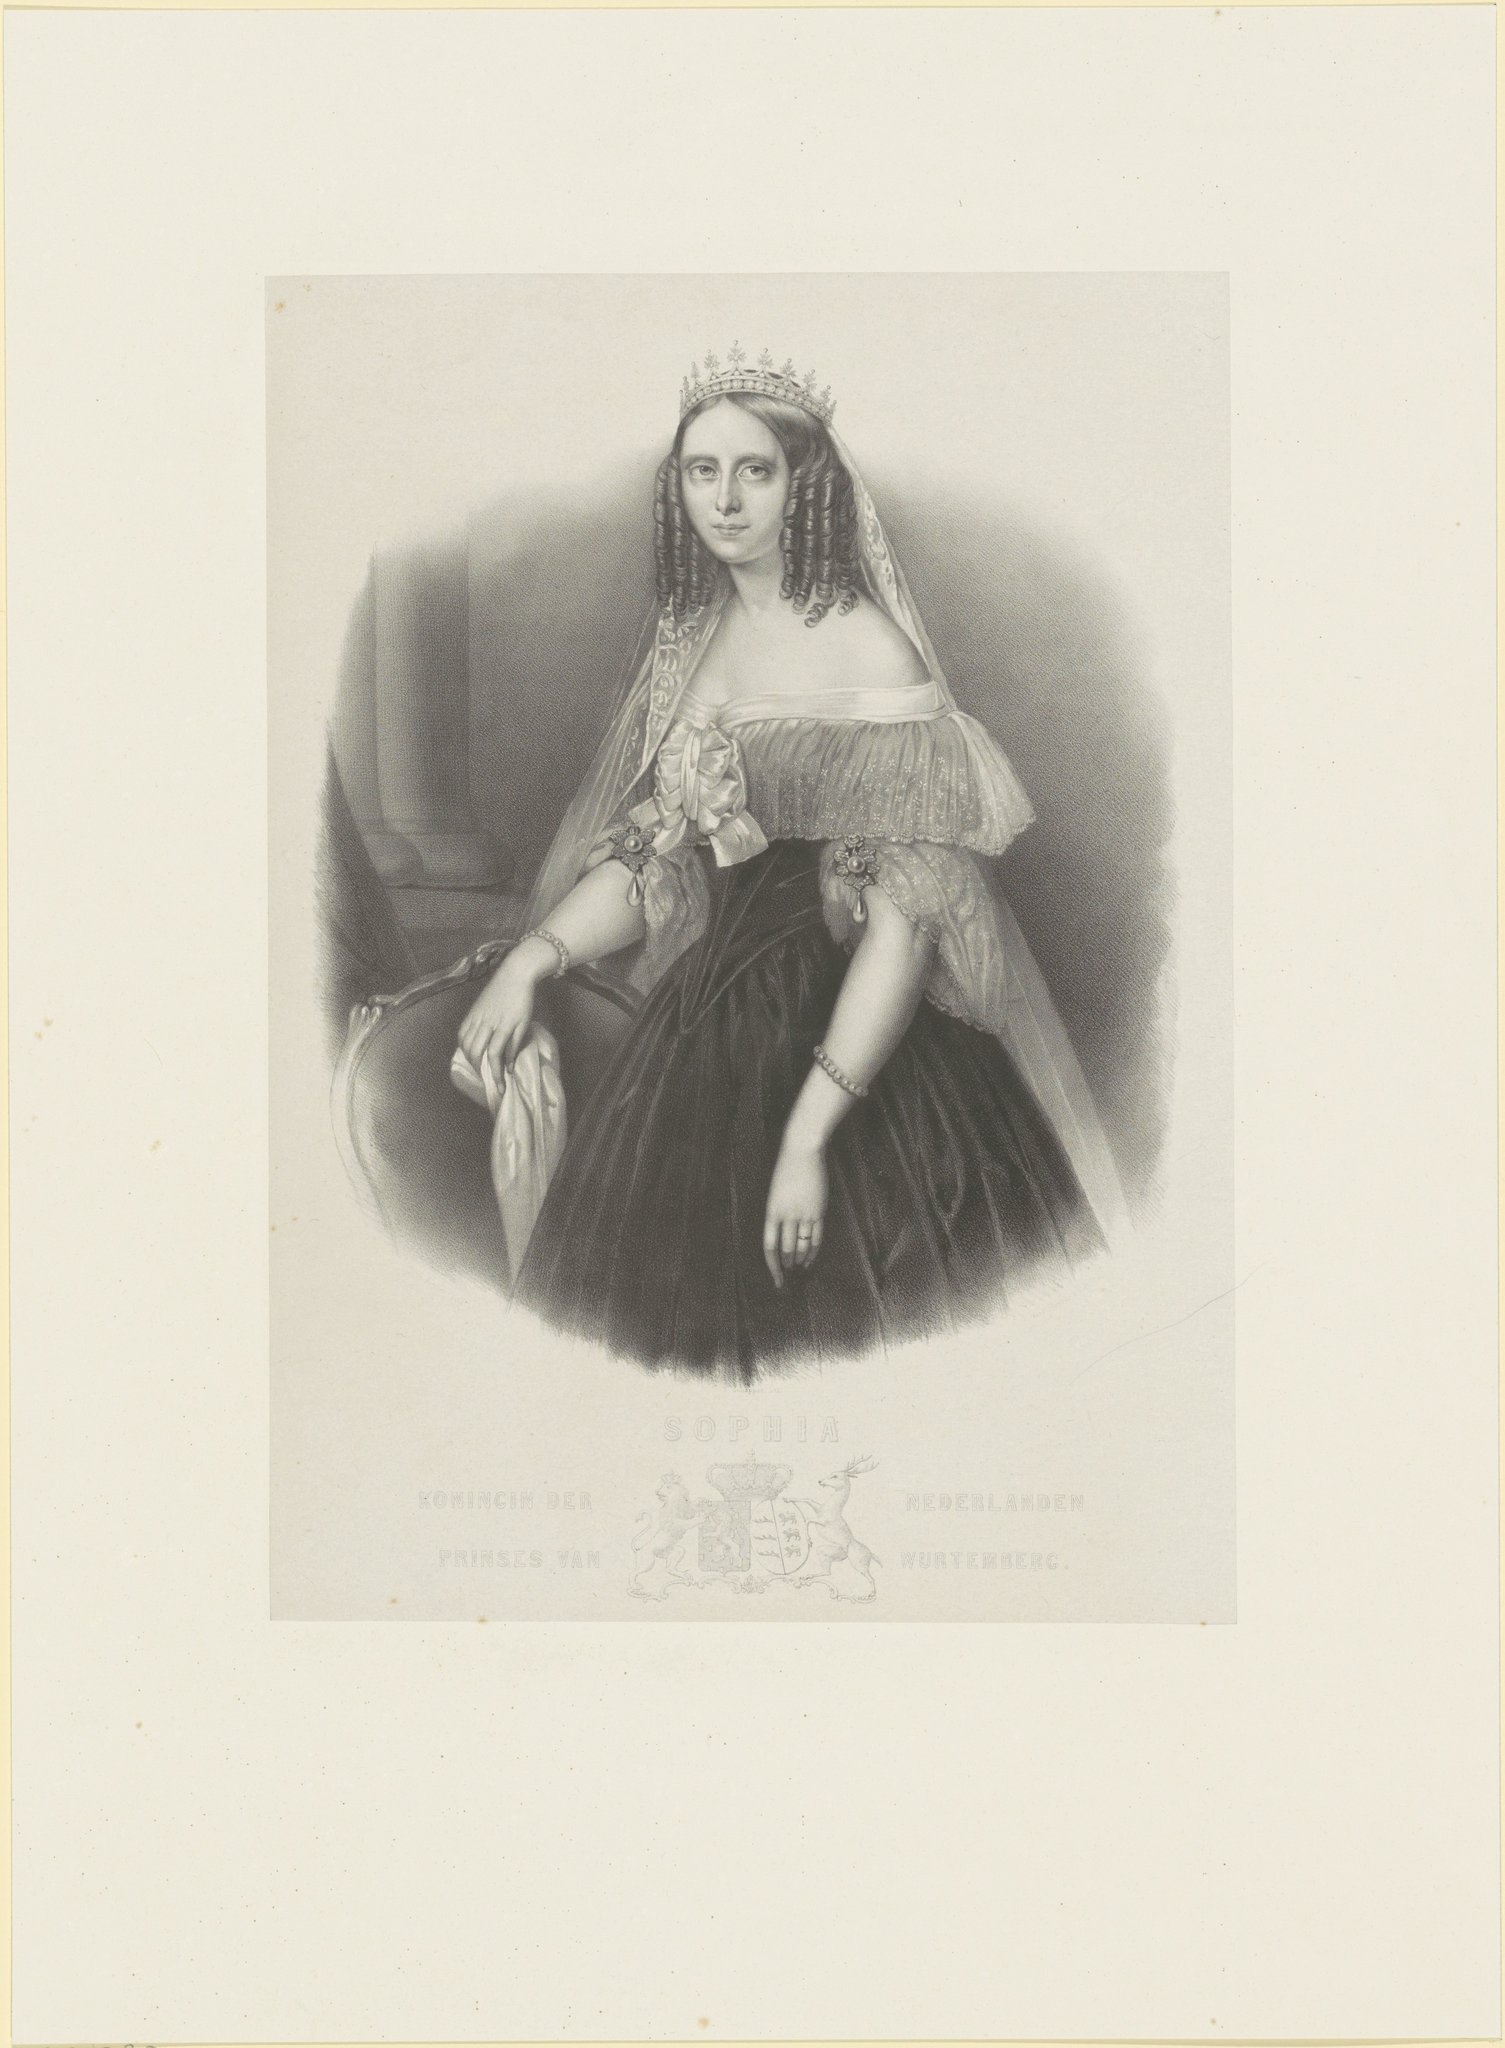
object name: print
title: Portret van Sophie van Württemberg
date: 1849-1871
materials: paper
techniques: lithograph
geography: the hague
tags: the hague, sophia frederika mathilda van württemberg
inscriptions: collector's mark: Lugt 963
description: Portret van Sophie. Midden onder twee wapens met een kroon, een leeuw en een hert. In de ondermarge haar naam en titels.